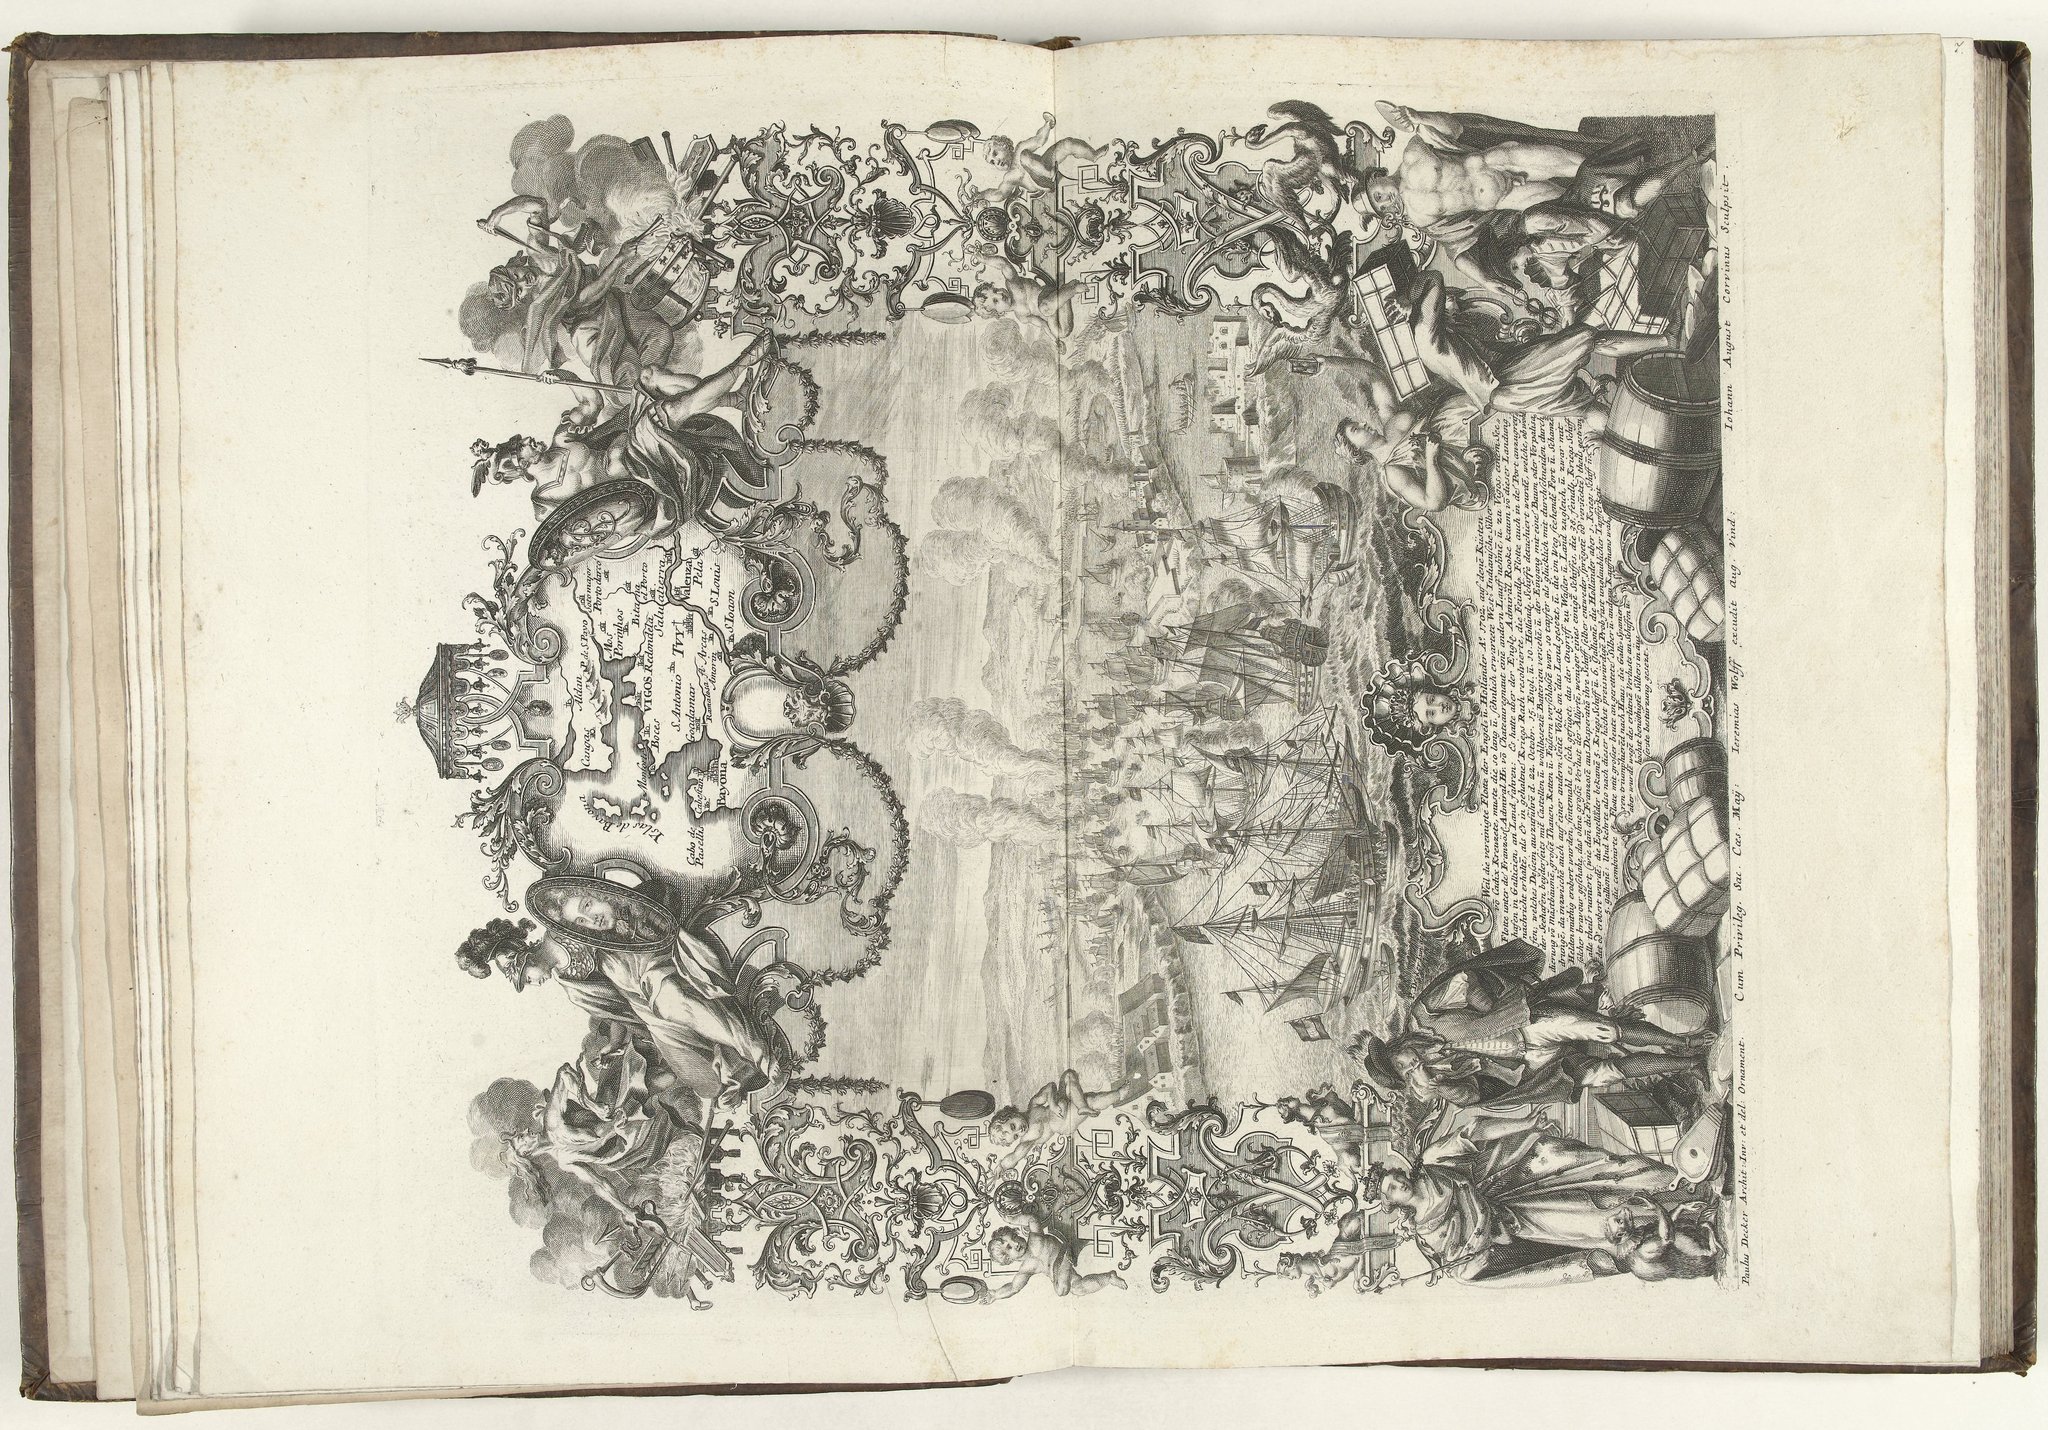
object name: history print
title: Zeeslag in de baai van Vigo, 1702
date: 1712-1715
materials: paper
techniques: engraving, etching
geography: augsburg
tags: battle (+ naval force)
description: Zeeslag in de baai van Vigo. De Frans-Spaanse vloot wordt op 23 oktober 1702 verslagen door de gecombineerde Engels-Hollandse vloot waarbij de zilvervloot wordt buitgemaakt. Voorstelling in een rijk versierde ornamentele omlijsting met met bovenaan een kaart van het gebied rond Vigo. Onderaan in het midden een cartouche met een beschrijving van de gevechten in het Duits, links Frankrijk met een aap en een bedroefde koopman, rechts Mercurius en twee koopmannen met koopwaar. Blad in de gebonden verzameling platen uitgebracht onder de titel: Repraesentatio belli ... Der Spanische Successions-Krieg [ca. 1720].